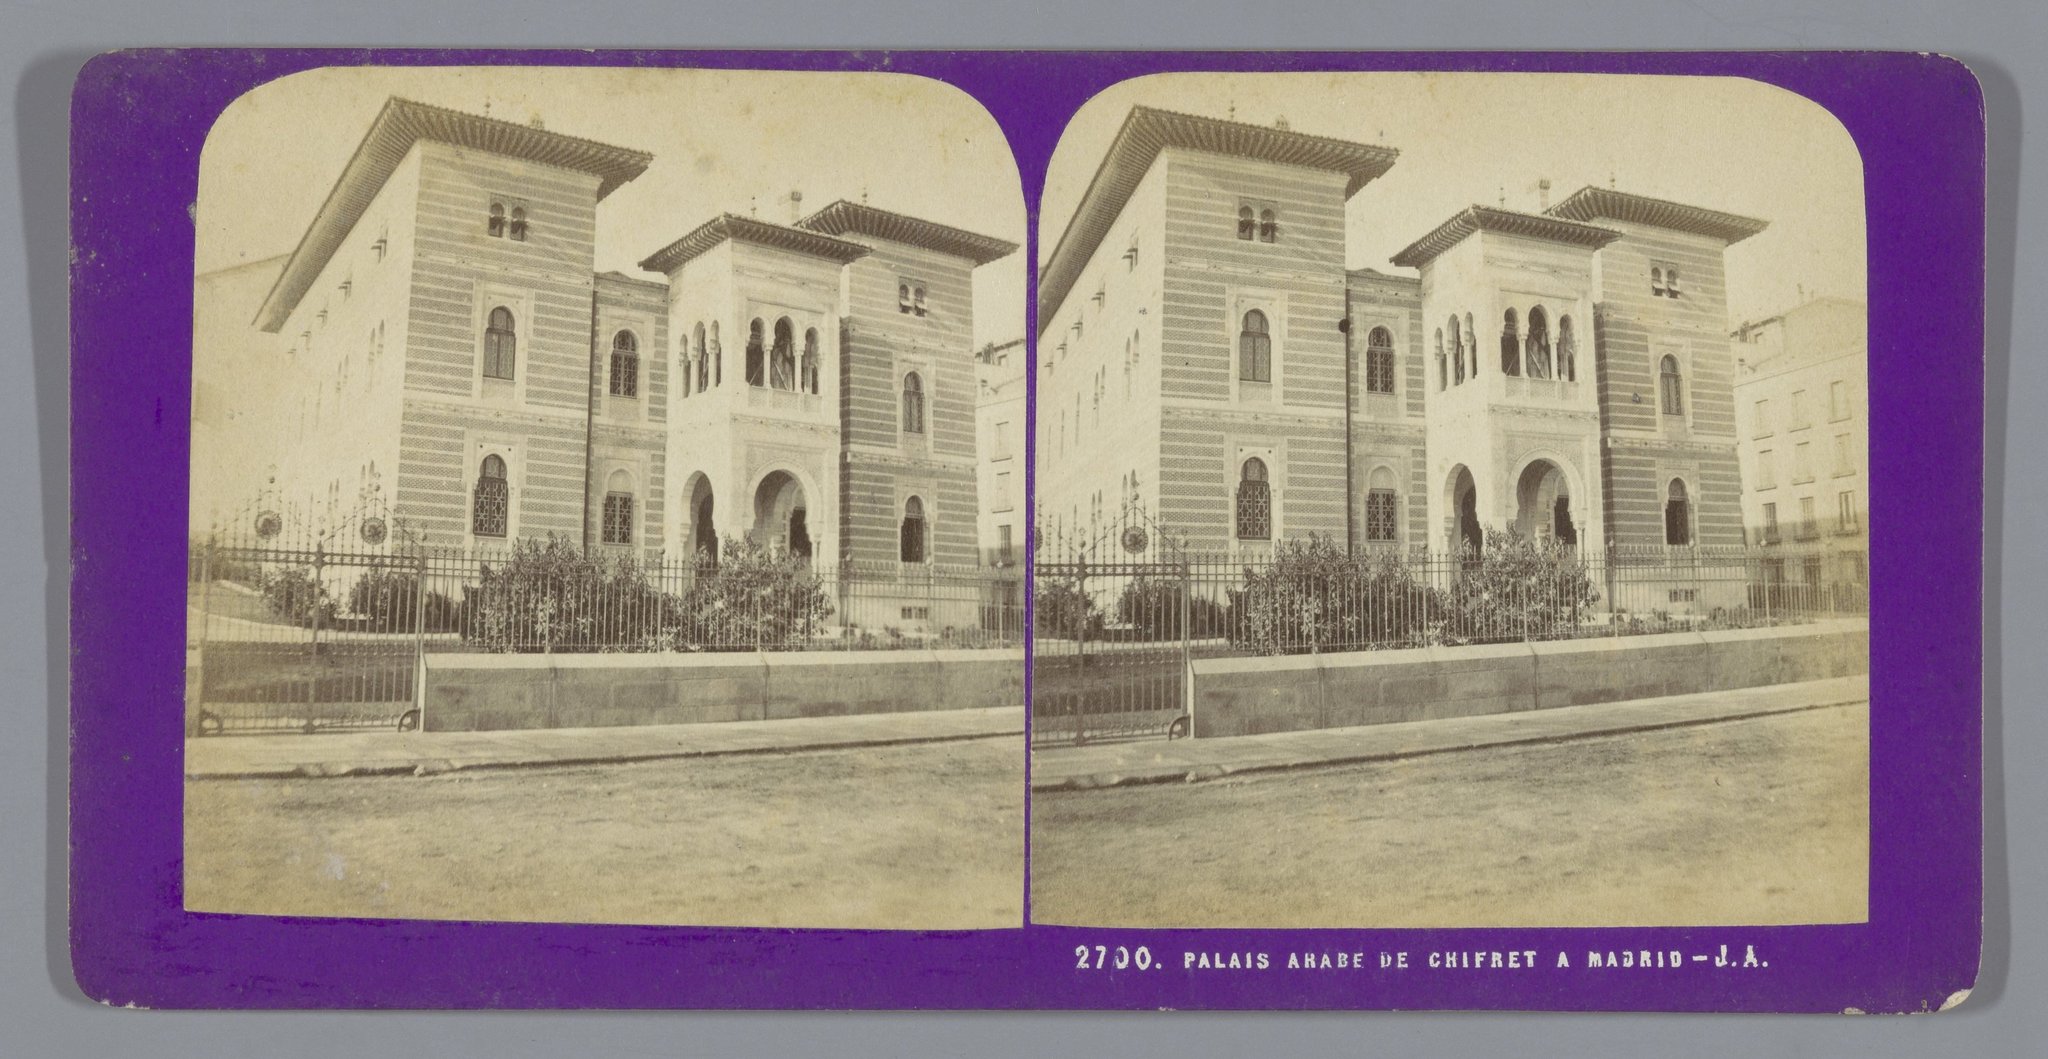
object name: stereograph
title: PALAIS ARABE DE CHIFRET A MADRID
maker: jean andrieu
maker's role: fotograaf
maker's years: 1816-1872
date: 1862-1876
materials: cardboard, photographic support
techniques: albumen print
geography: madrid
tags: façade (of house or building)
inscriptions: number: ‘2700.’